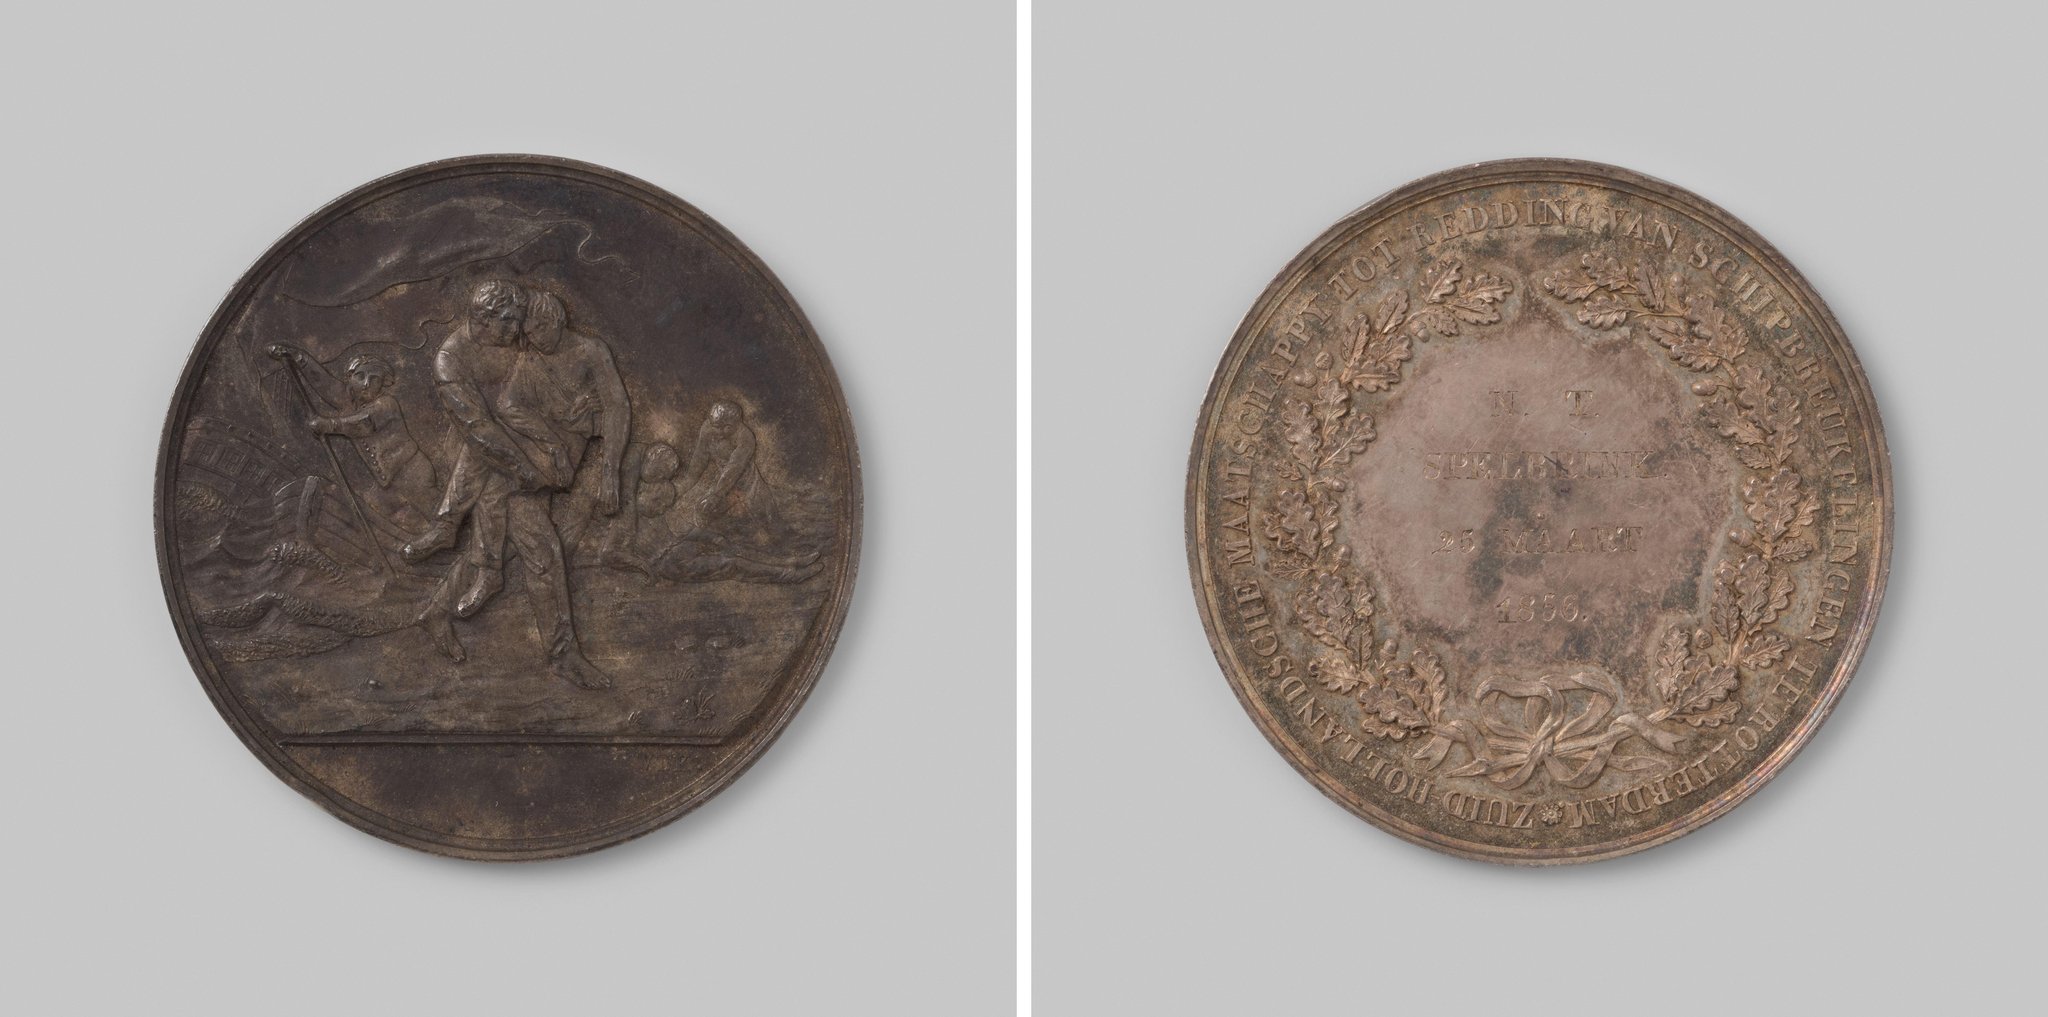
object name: honorary medal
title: Zuid-Hollandsche Maatschappy tot redding van schipbreukelingen te Rotterdam, penning uitgereikt aan N.T. Spelbrink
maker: david van der kellen (1804-1879)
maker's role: die cutter, draughtsman, print maker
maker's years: 1804-1879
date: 1856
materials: silver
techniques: engraving, striking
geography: utrecht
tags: rotterdam